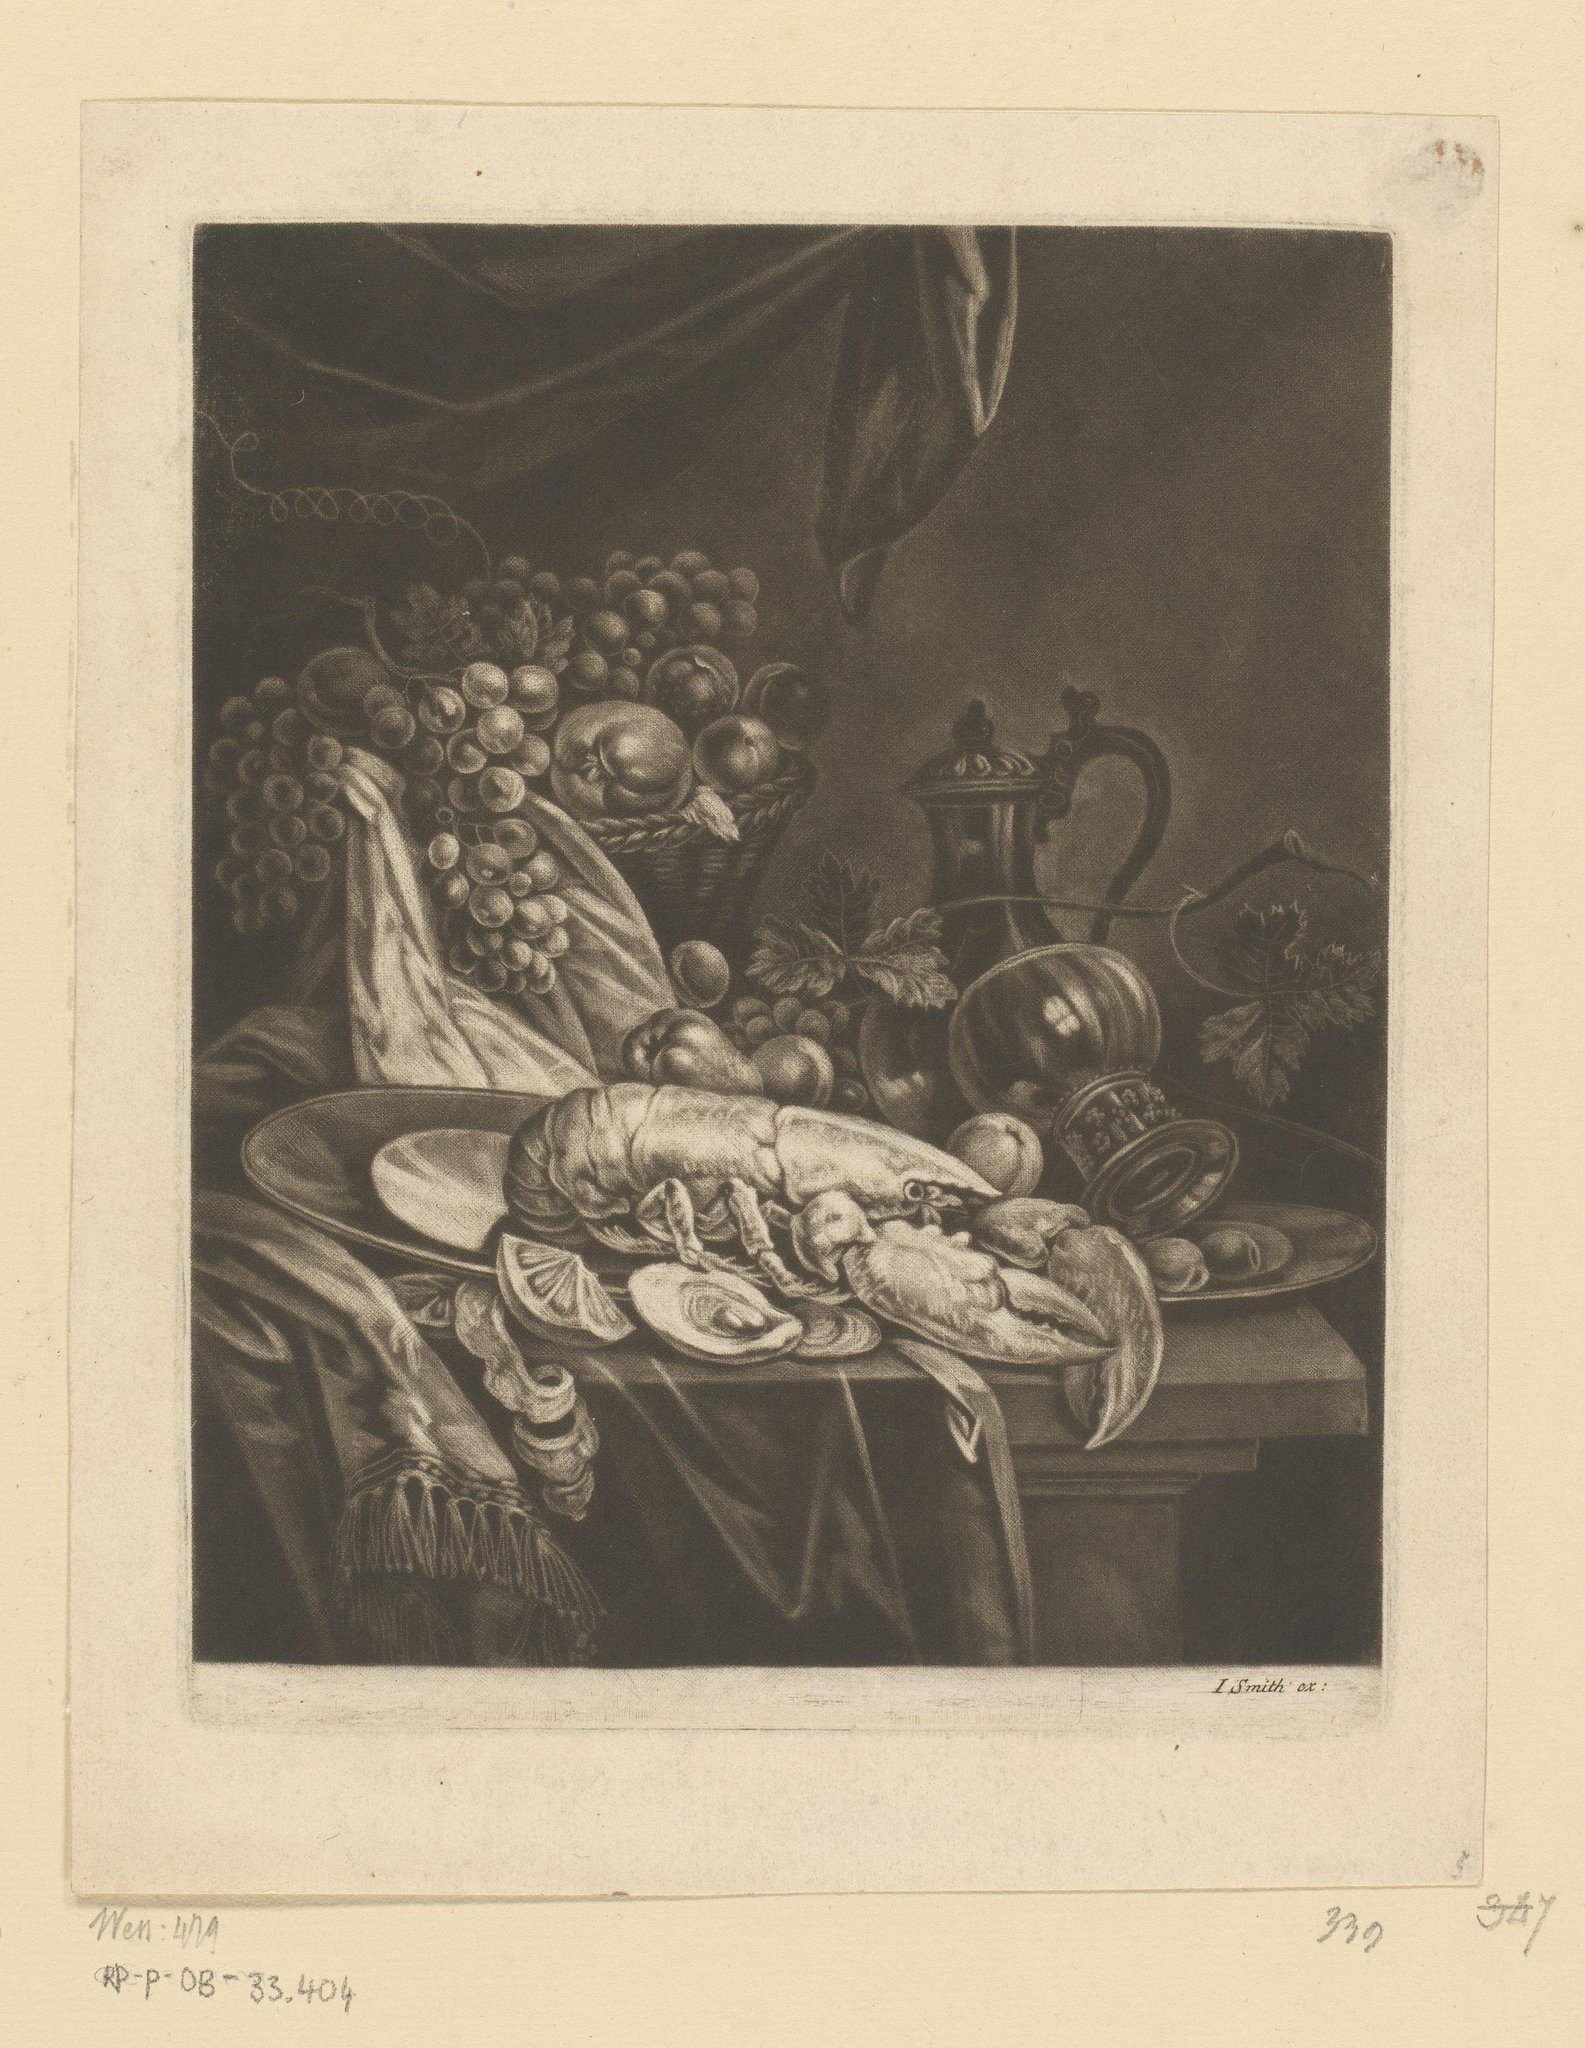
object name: print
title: Stilleven met fruit en een kreeft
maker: john smith (prentmaker/ uitgever)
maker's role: print maker, publisher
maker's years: 1652-1743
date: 1662-1742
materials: paper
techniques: mezzotint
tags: 'vanitas' still life, laid table as still life, foodstuffs; still life of foodstuffs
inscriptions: collector's mark: Lugt 240